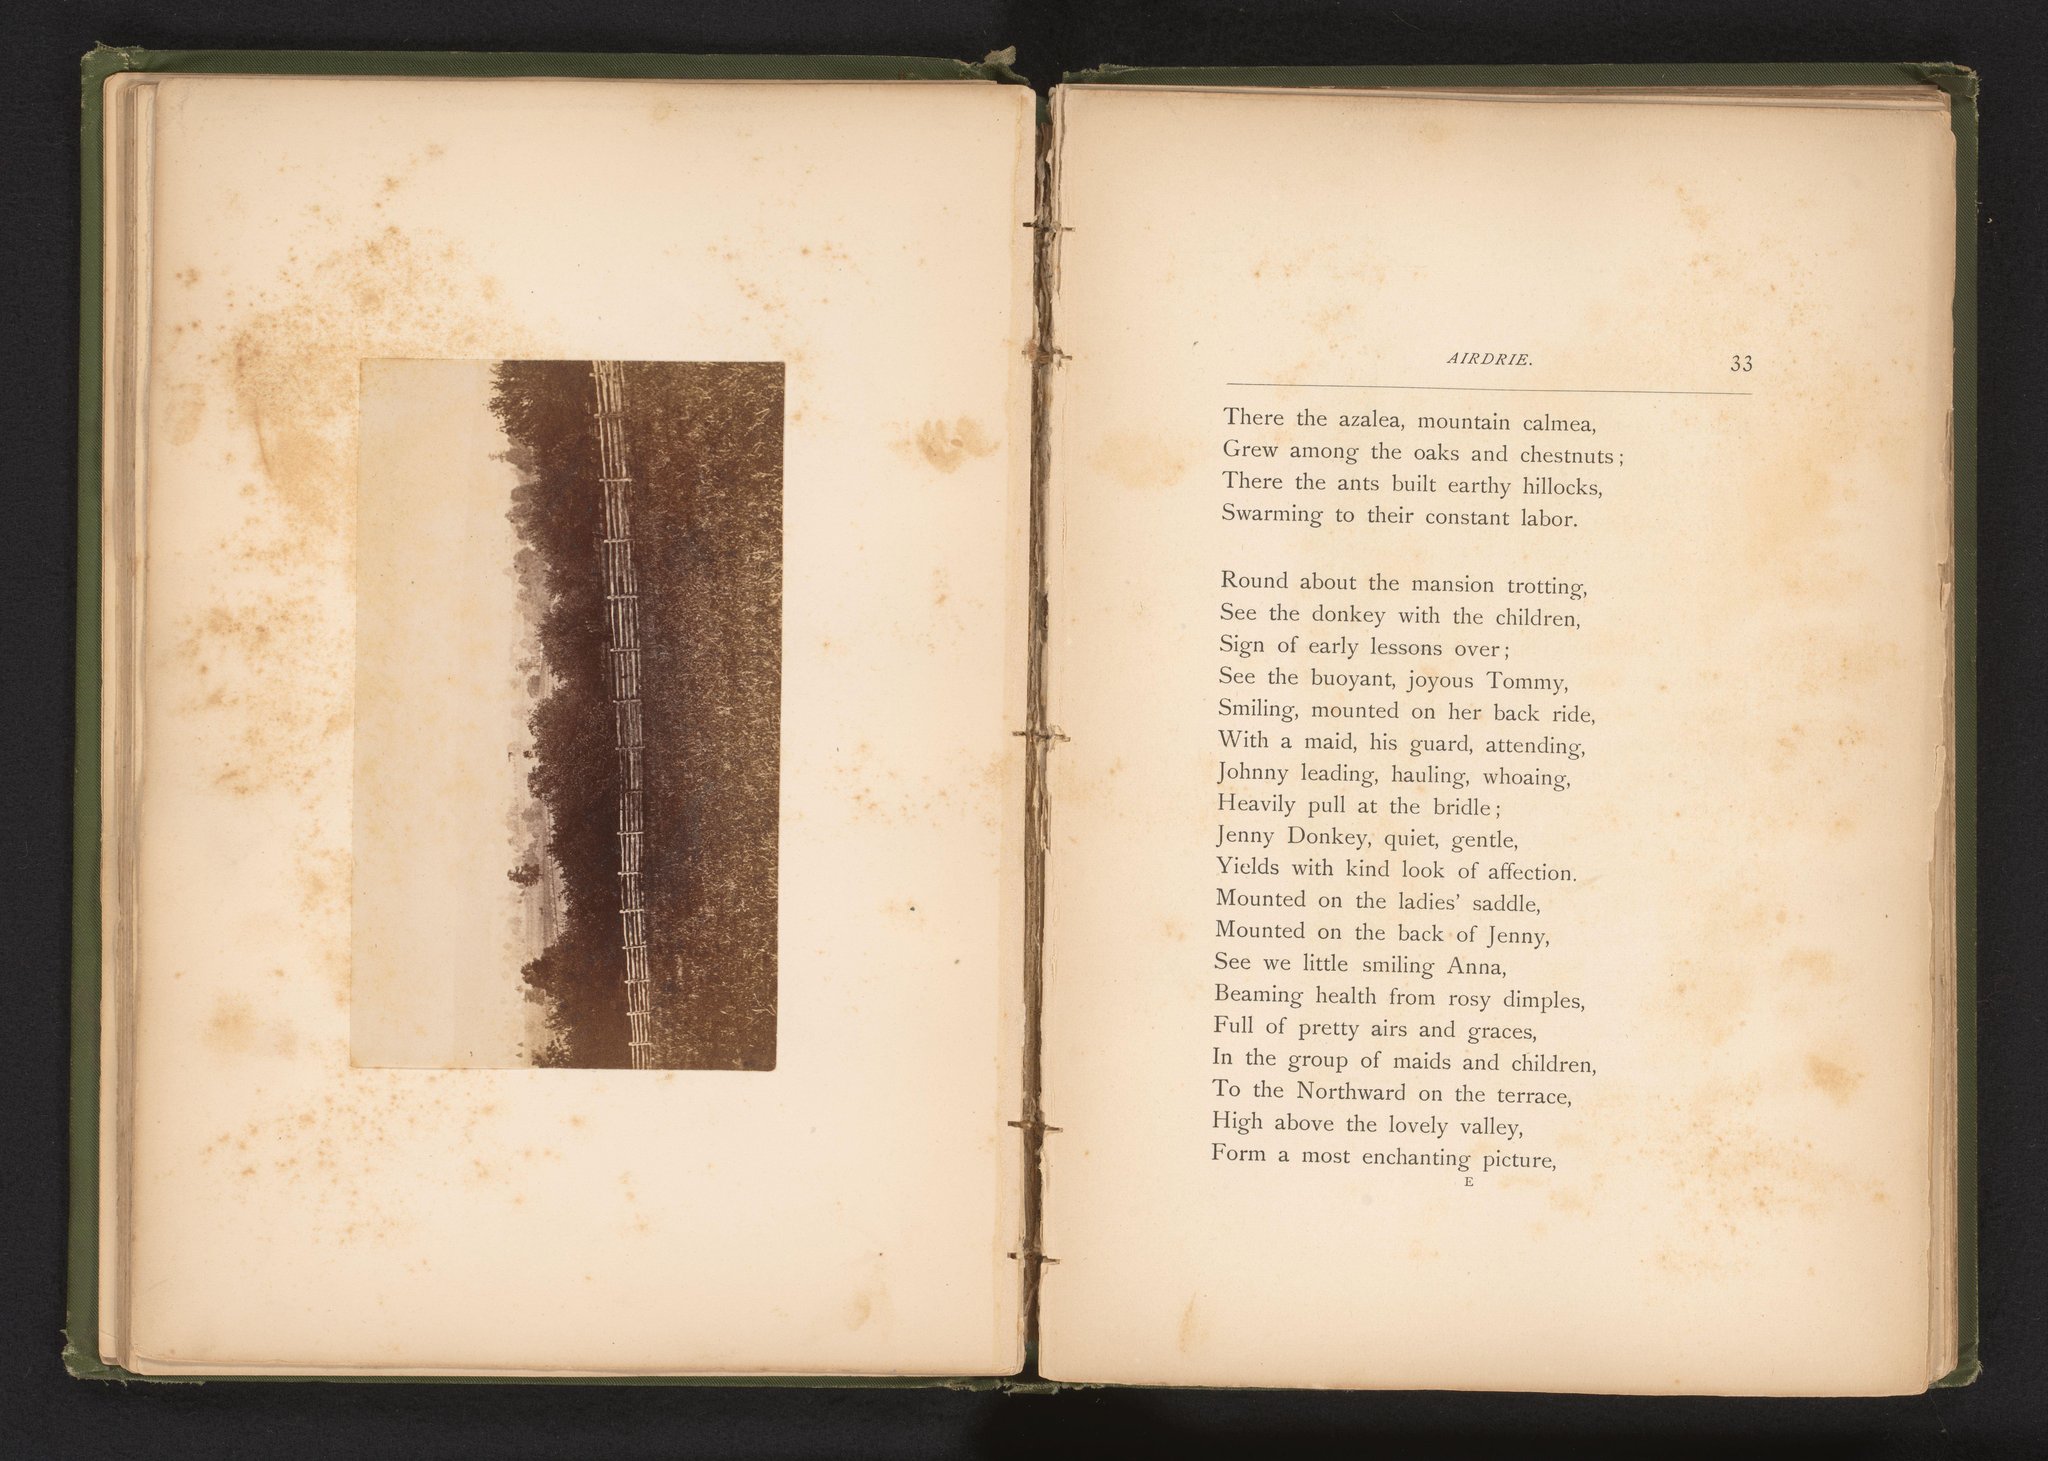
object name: photograph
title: Gezicht op Valley Forge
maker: Anonymous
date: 1871-1876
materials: photographic support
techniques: albumen print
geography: valley forge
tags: dale, valley